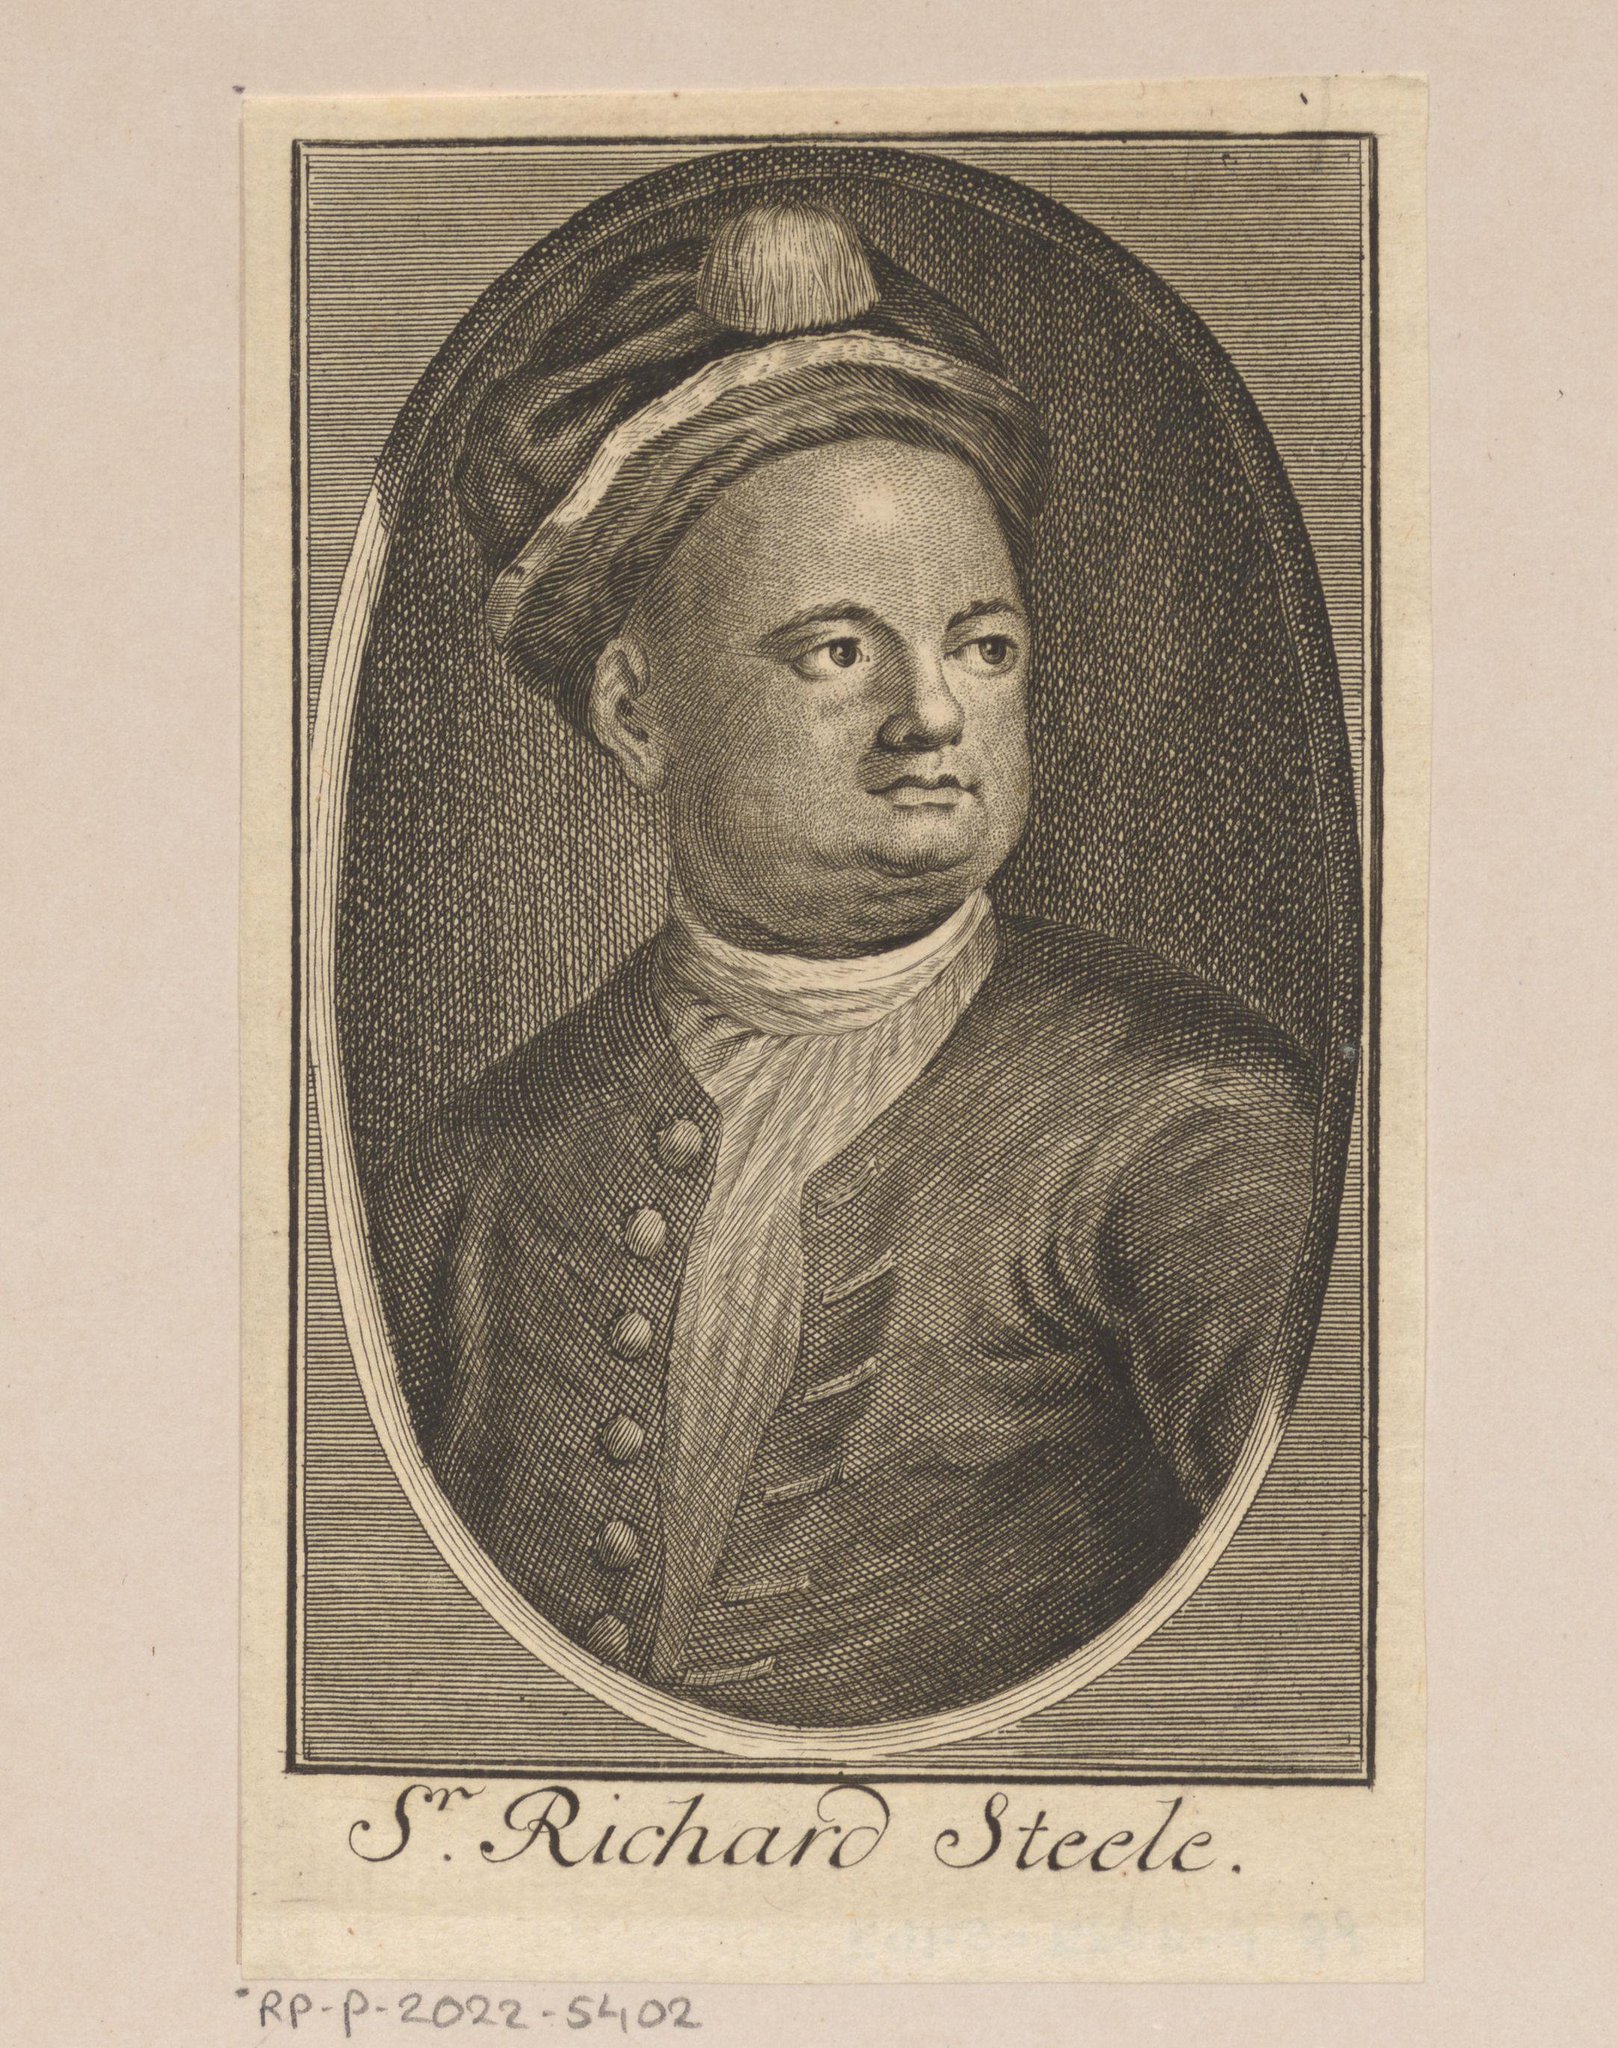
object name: print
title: Portret van Richard Steele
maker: Anonymous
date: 1701-1799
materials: paper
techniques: engraving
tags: historical persons, portrait of a writer, politician, e.g. party leader